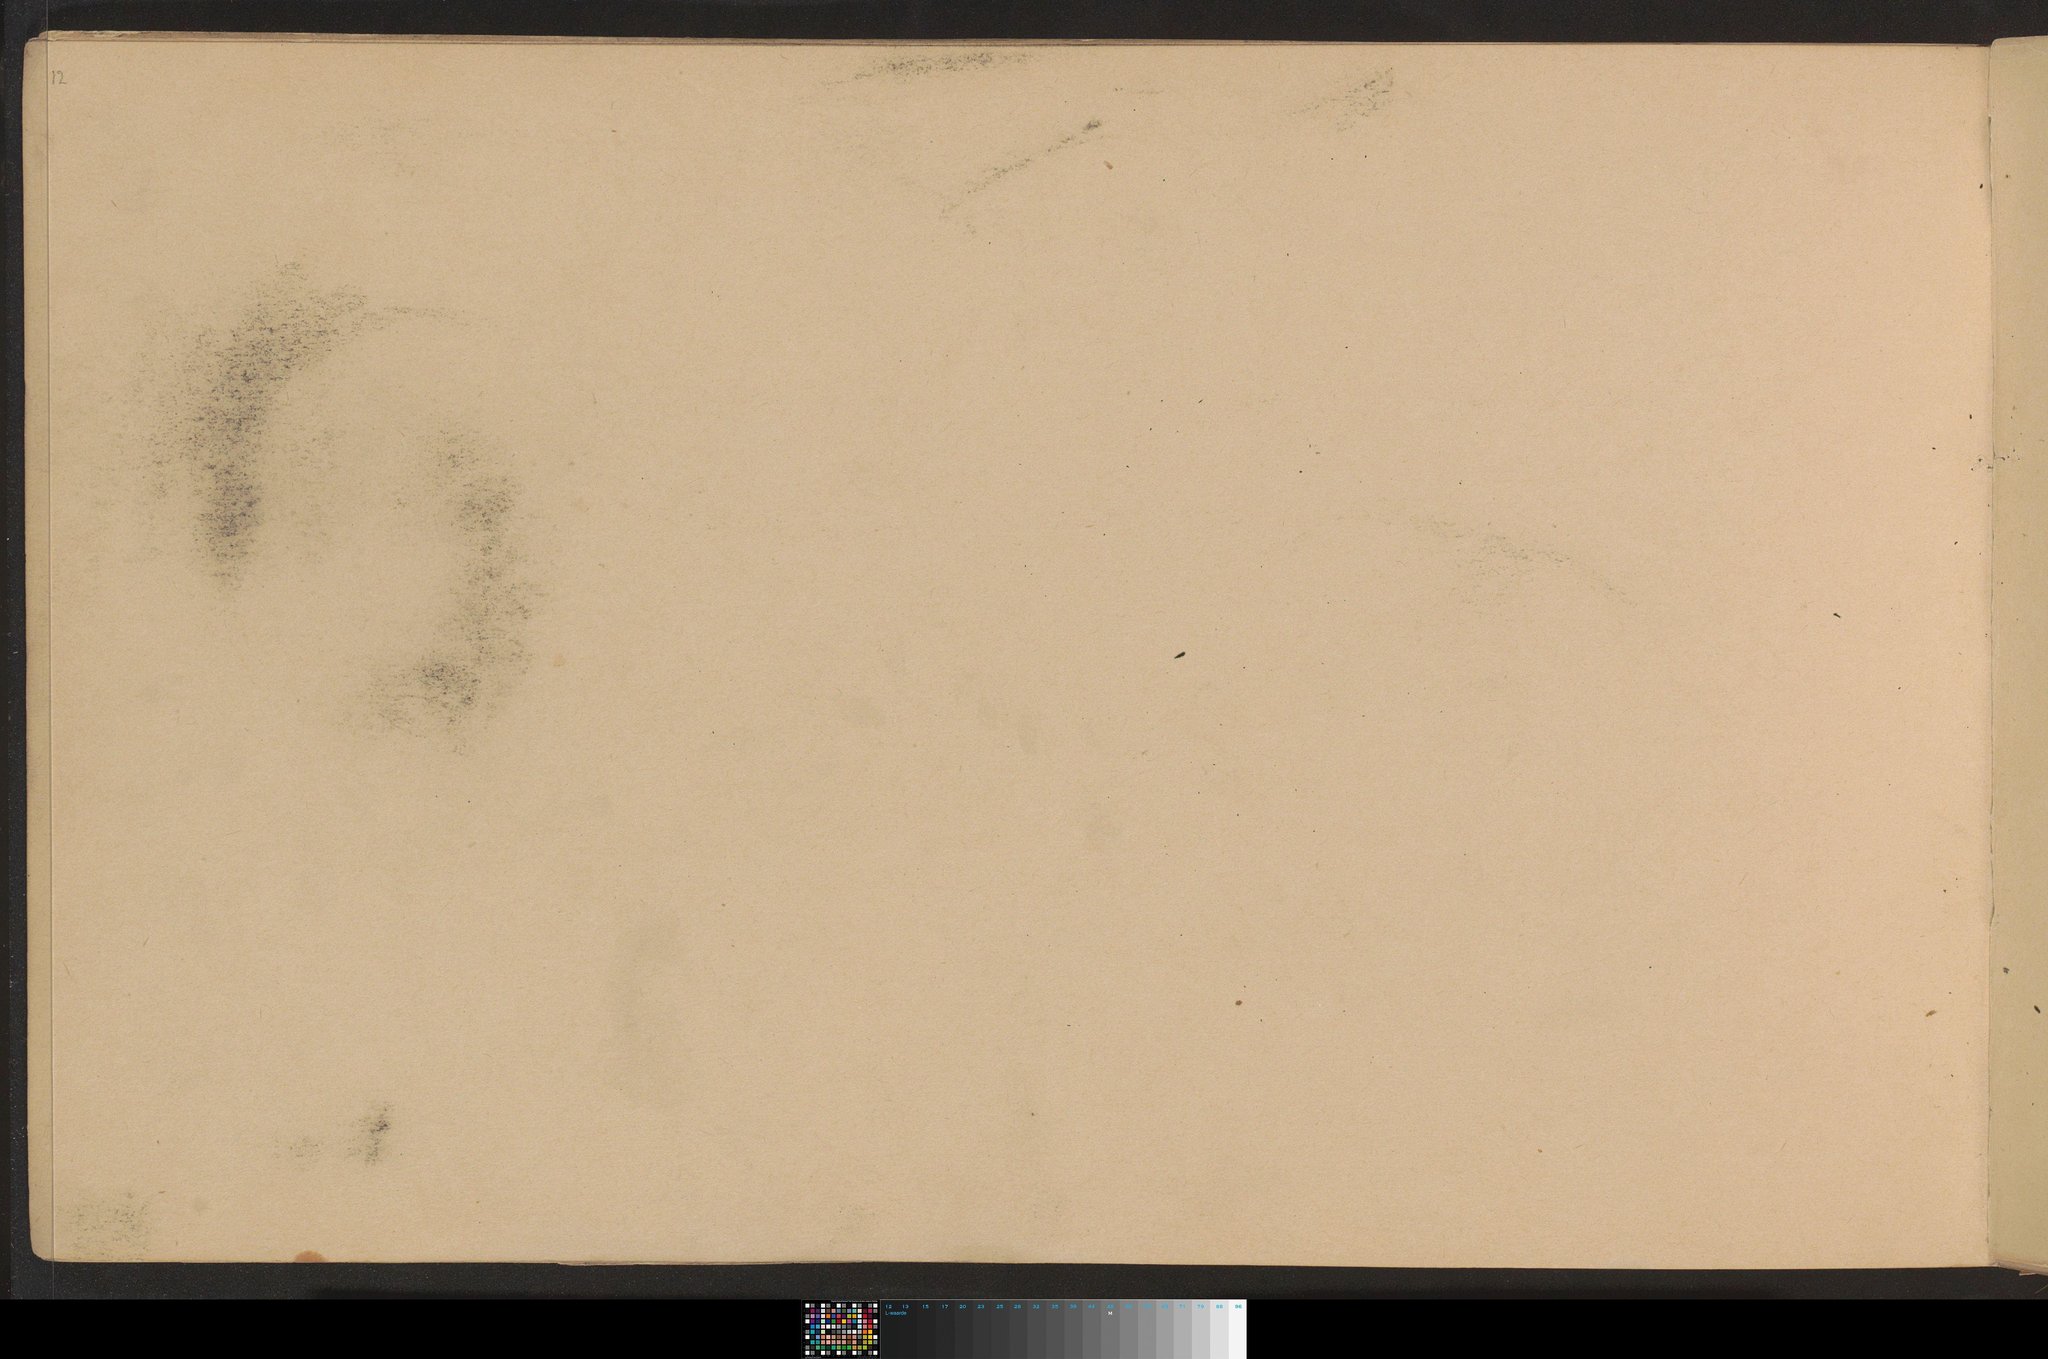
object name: sketchbook leaf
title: Abklatsch van de krijttekening op pagina 13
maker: willem witsen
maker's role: draughtsman, painter, print maker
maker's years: 1860-1923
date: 1897-1910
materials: paper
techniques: printmaking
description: Pagina 12 uit een schetsboek met 19 bladen.